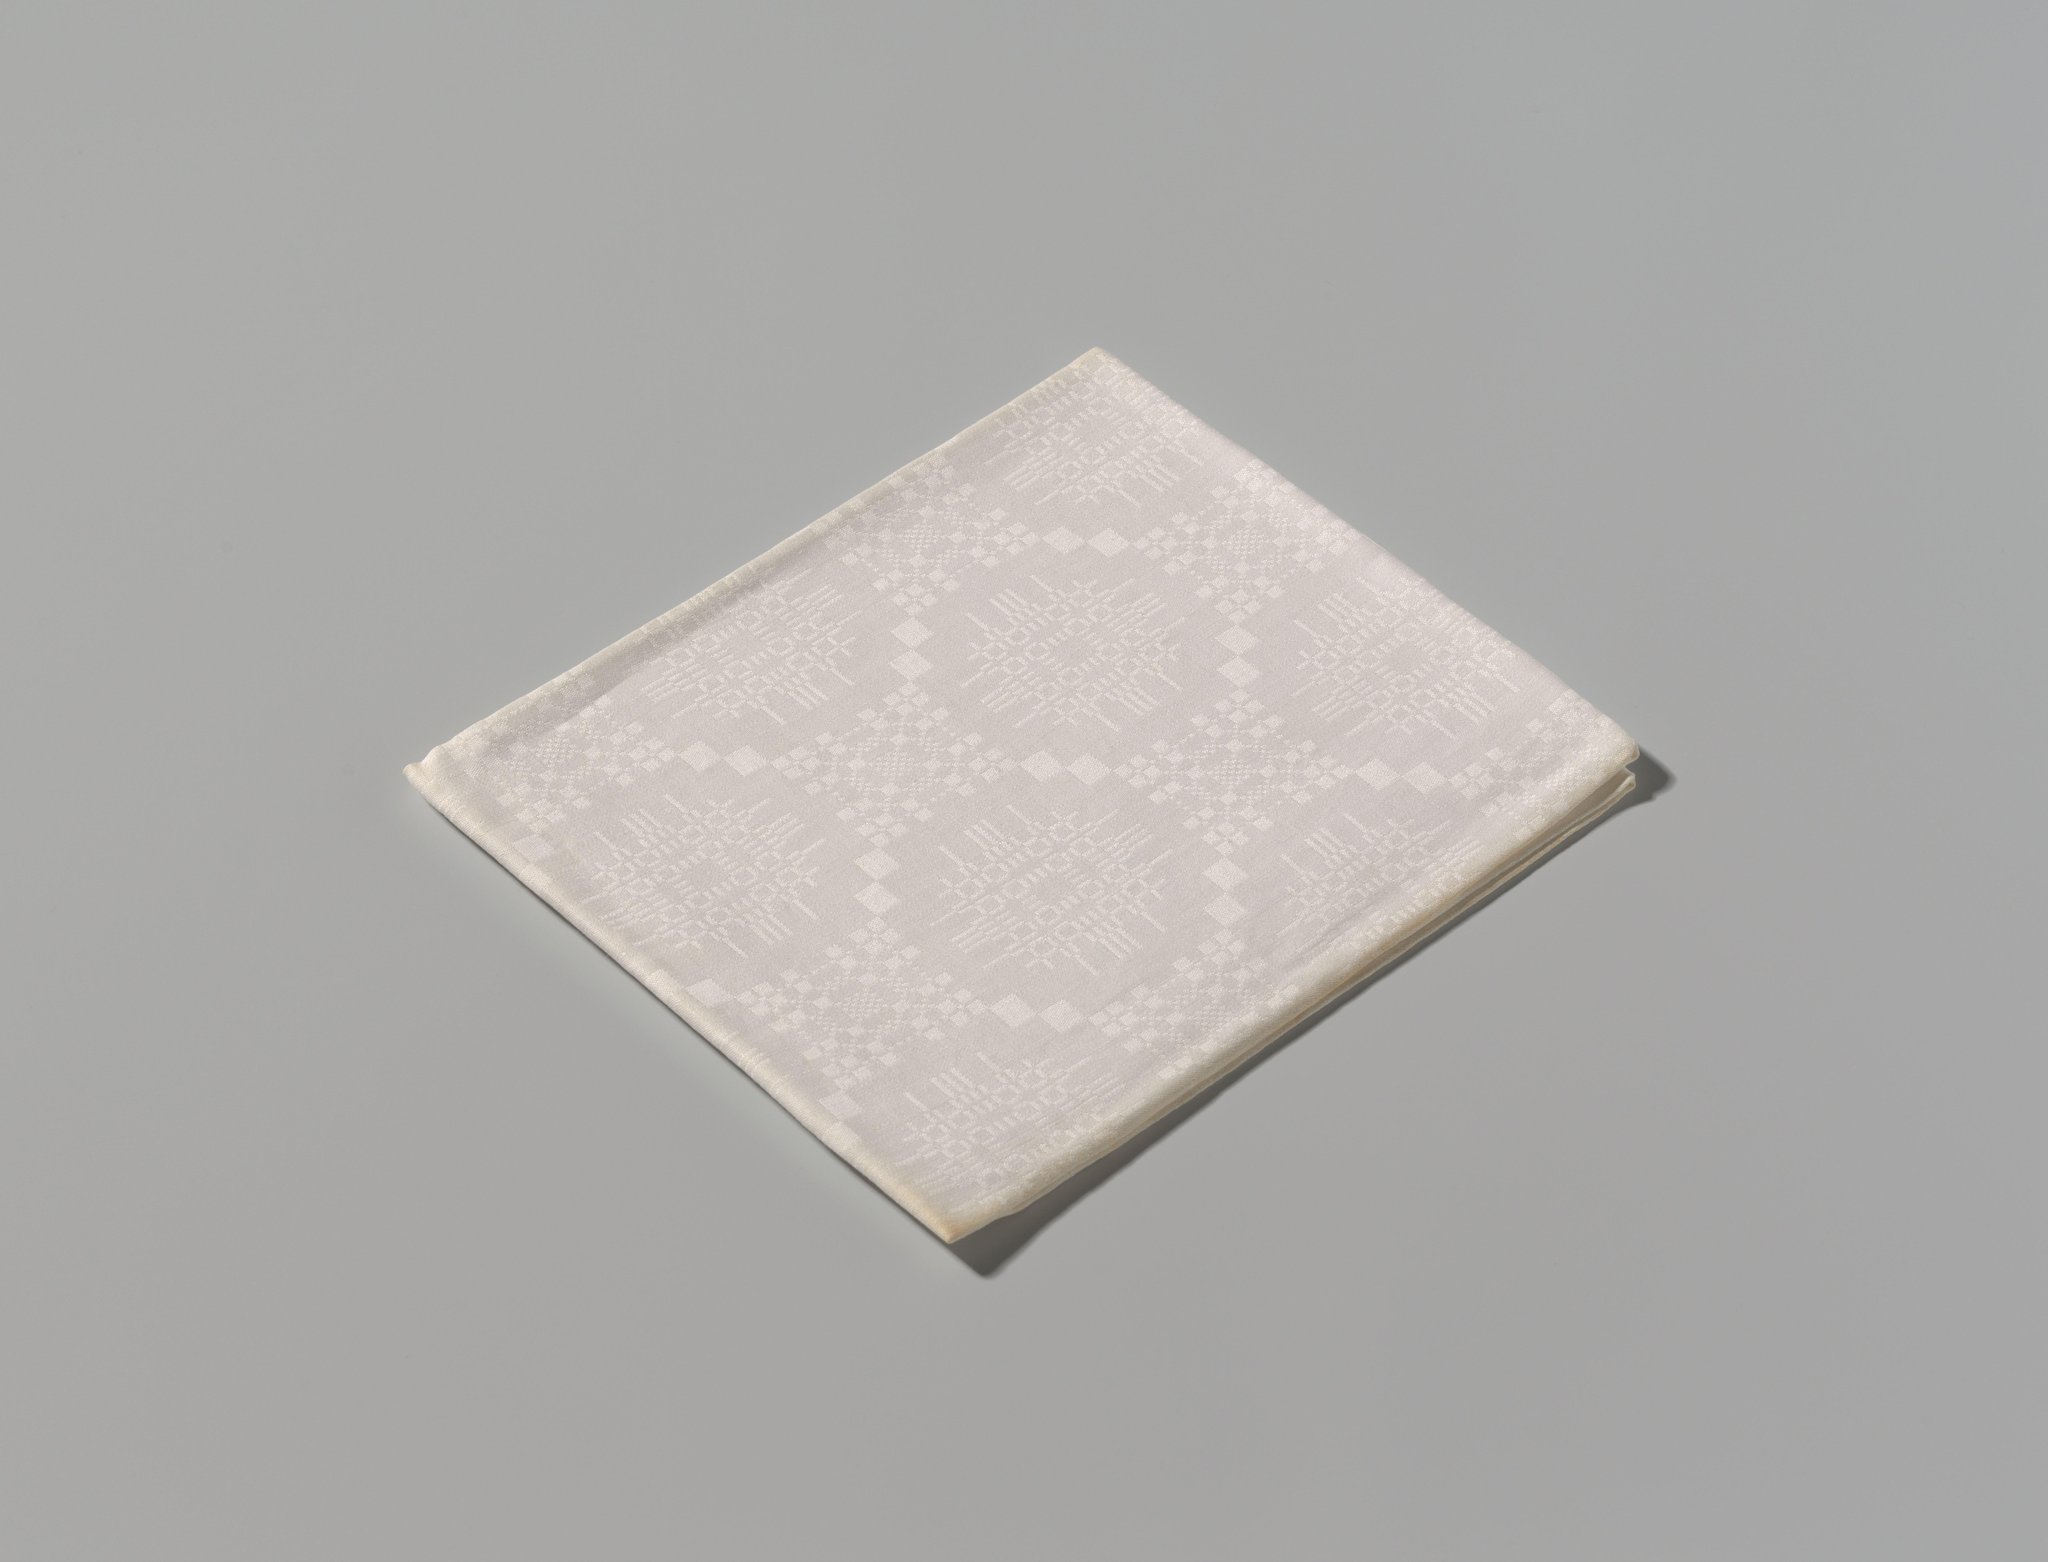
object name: napkin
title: Servet van pellendamast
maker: Anonymous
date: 1907-1925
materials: linen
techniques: weave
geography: netherlands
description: Servet van pellendamast met randen rondom. Het geometrische patroon heeft geblokte rozetten, vierkanten en lijnen. Het servet is in rood gemerkt met een kruissteek: HB 36.